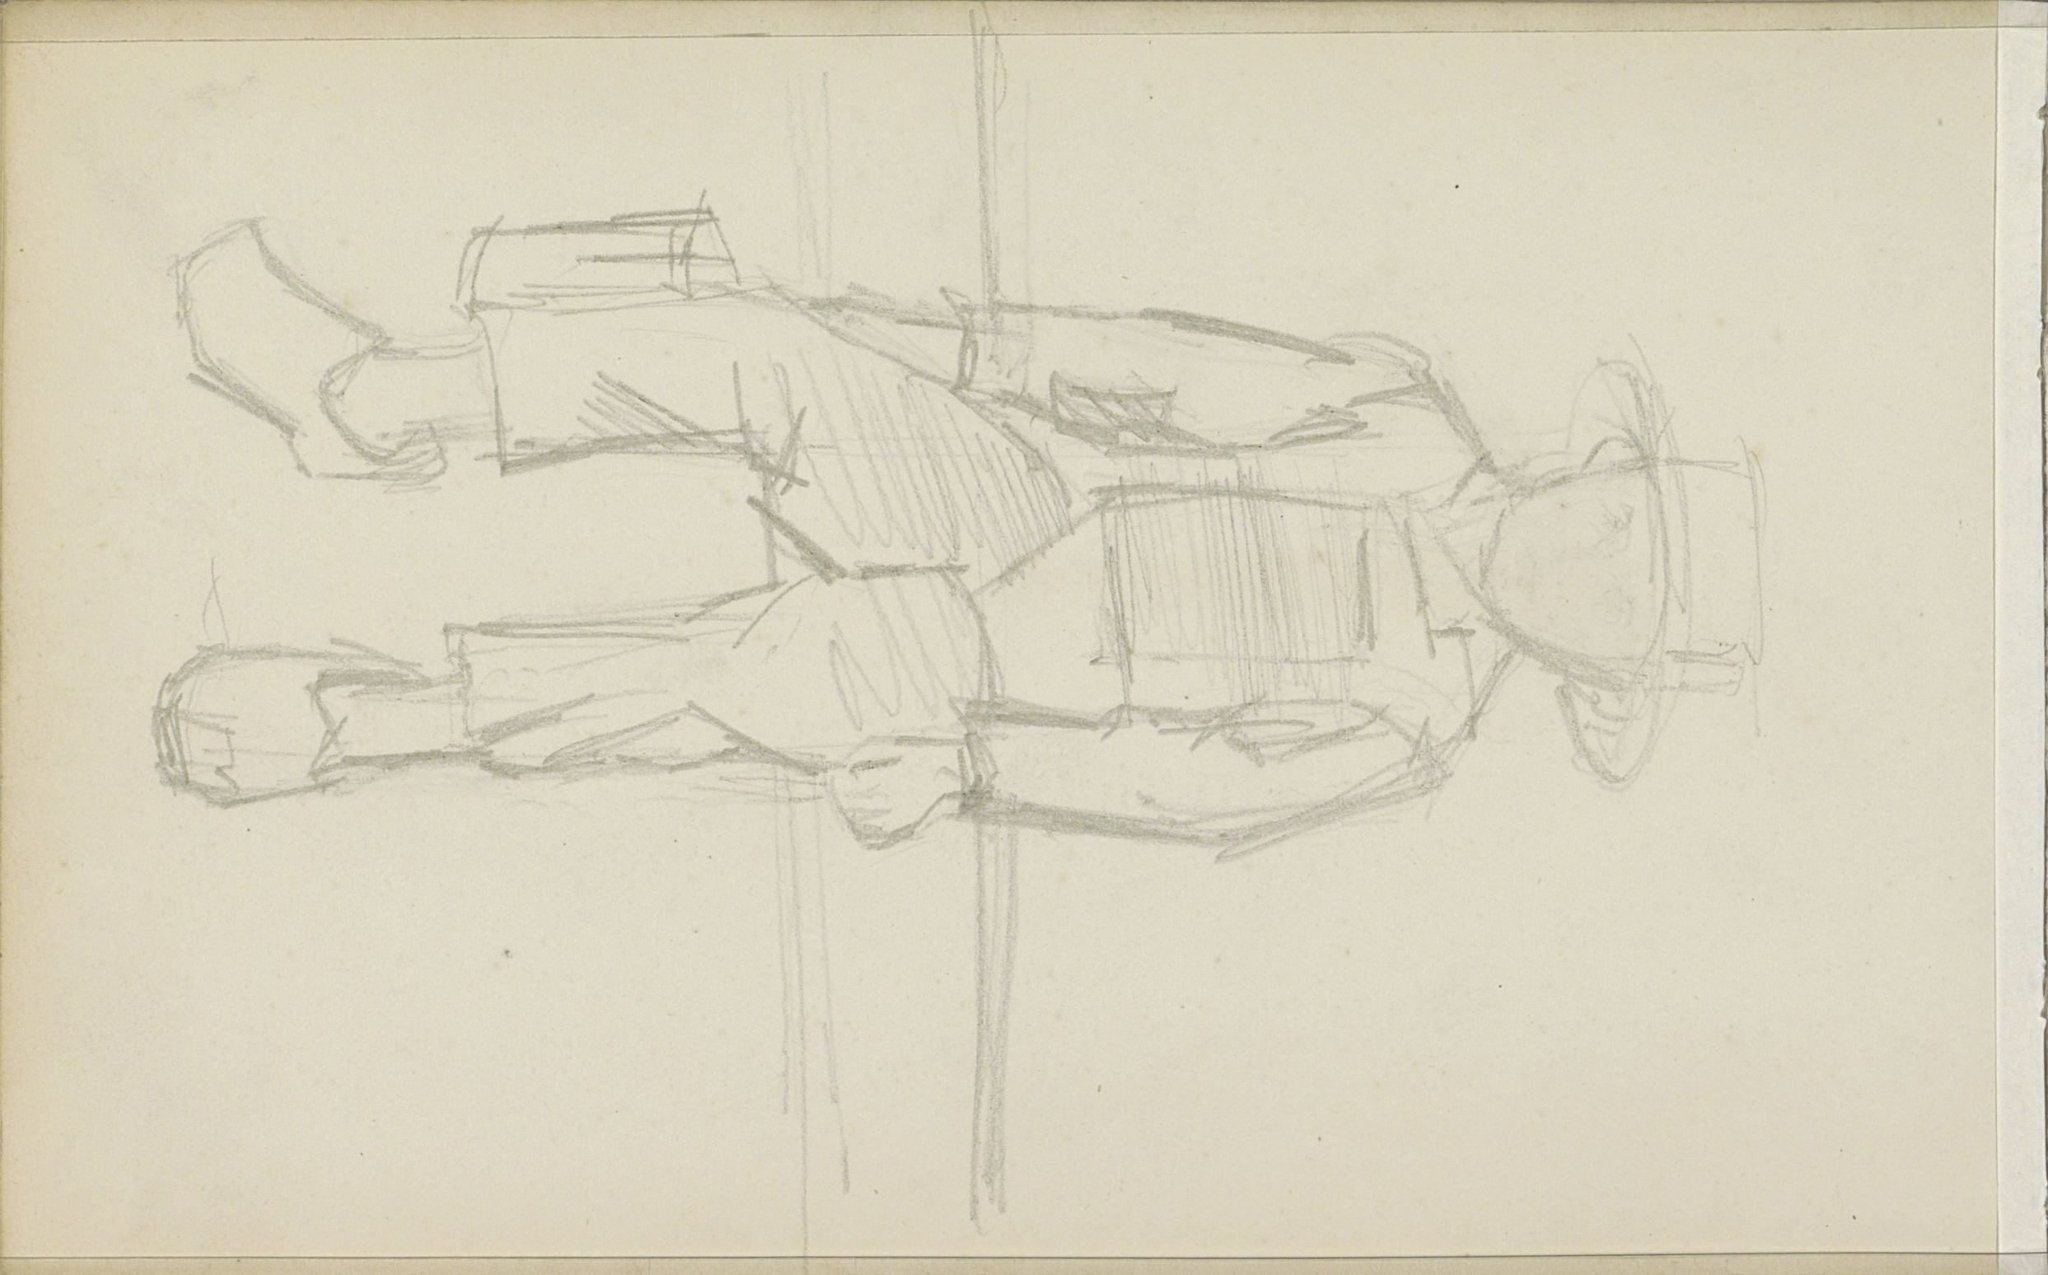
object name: sketchbook leaf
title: Zittende jongen met een hoed en klompen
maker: jozef israëls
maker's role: draughtsman, painter, print maker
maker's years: 1824-1911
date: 1834-1911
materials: paper, pencil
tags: wooden shoes, clogs, sitting figure (+ young male (human being))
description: Blad 10 verso uit een schetsboek met 37 bladen.